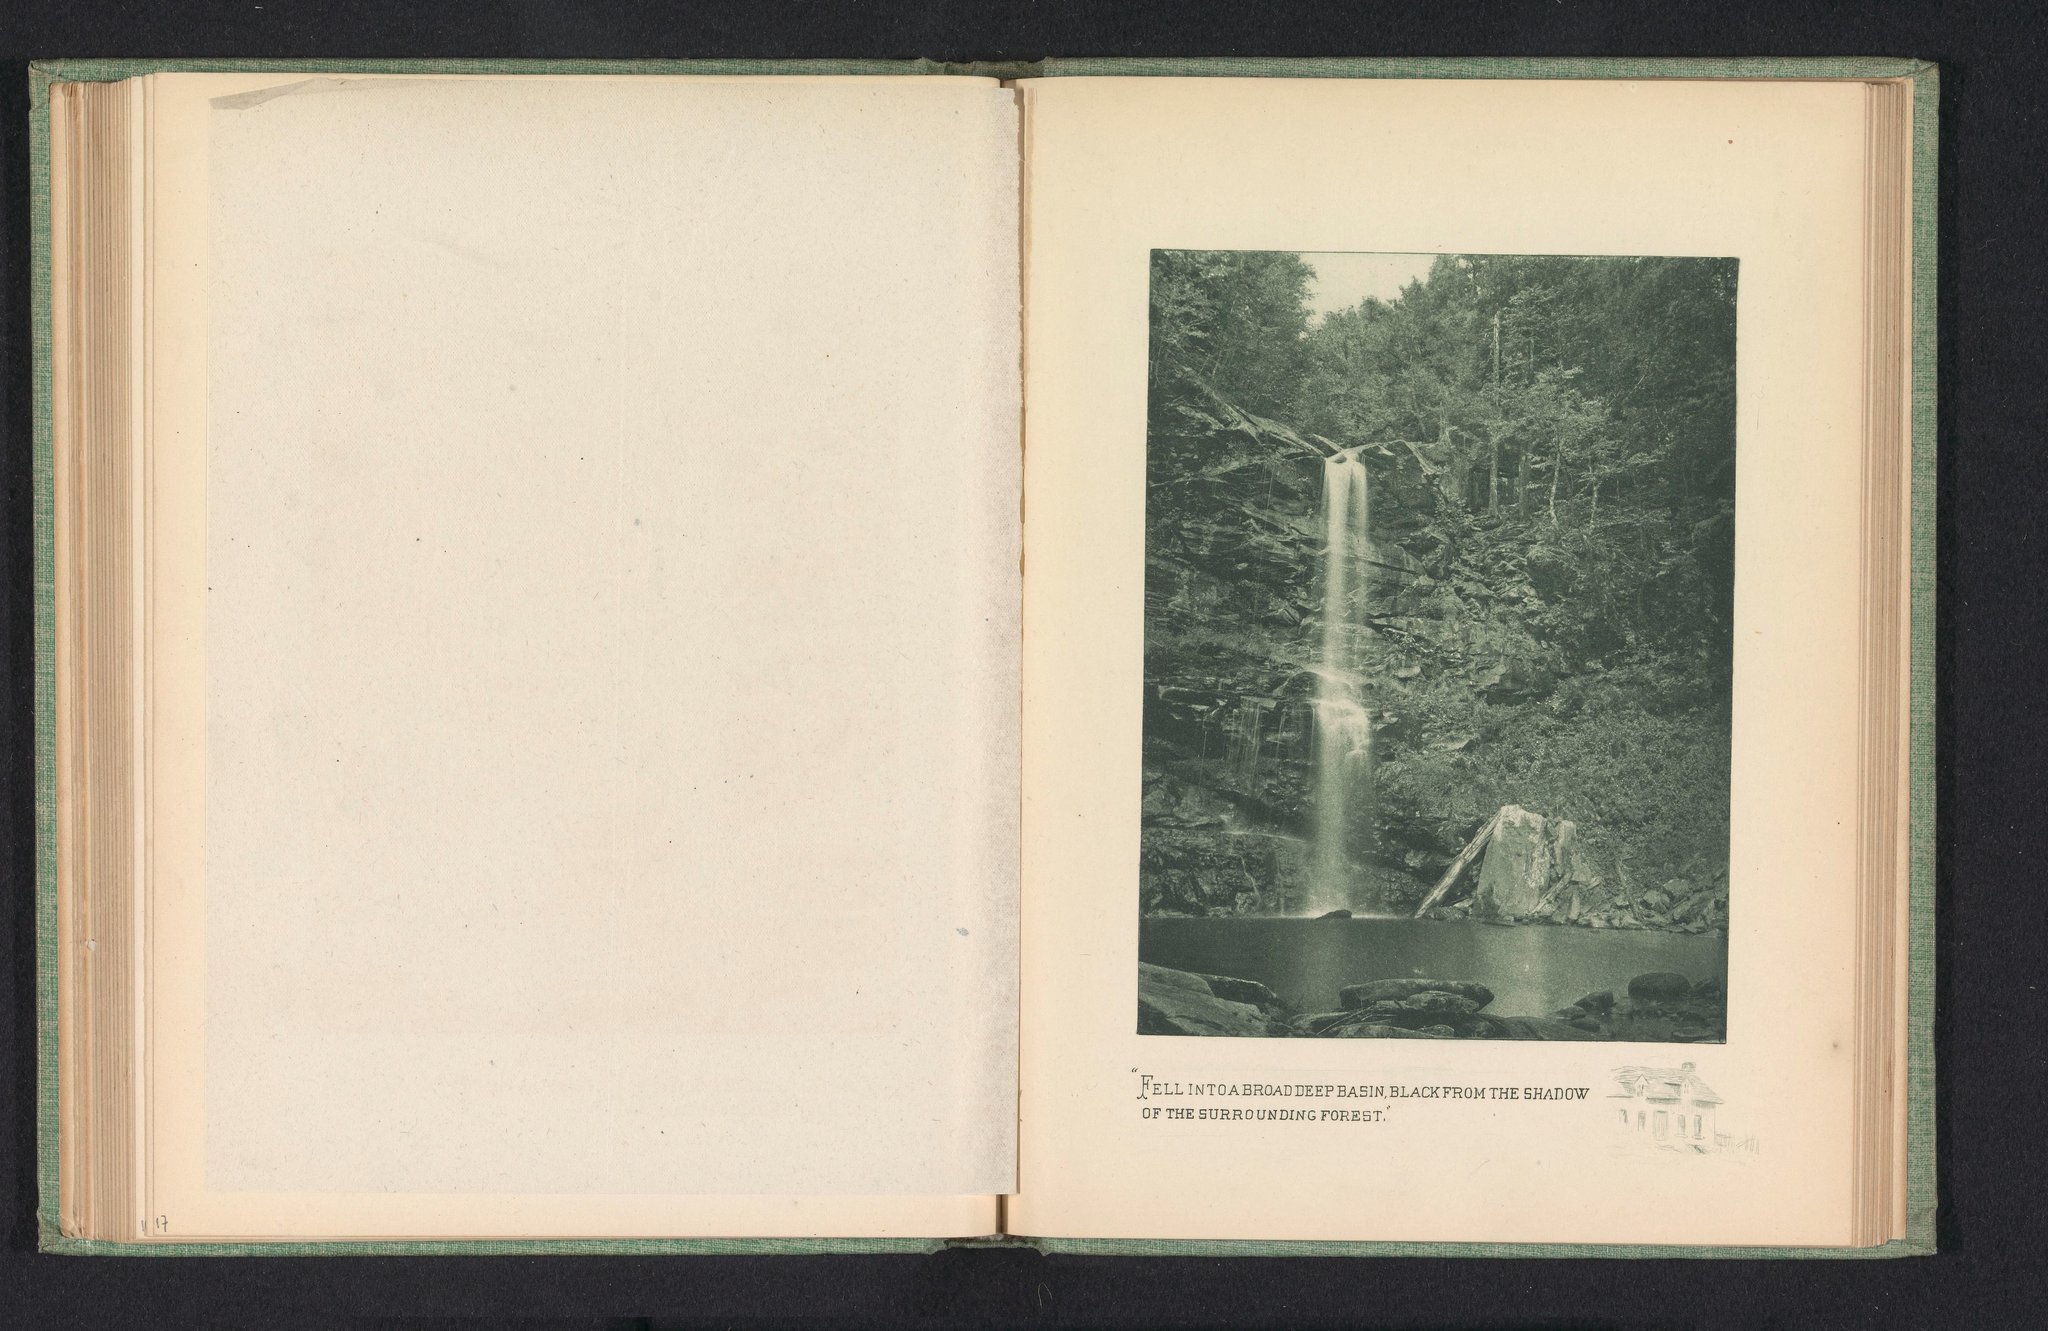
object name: photomechanical print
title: Gezicht op een waterval in het Catskillgebergte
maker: Anonymous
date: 1884-1894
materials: paper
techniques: photoaquatint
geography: catskill mountains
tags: waterfall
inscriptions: inscription: ‘“Fell into a broad deep basin, black from the shadow of the surrounding forest.”’